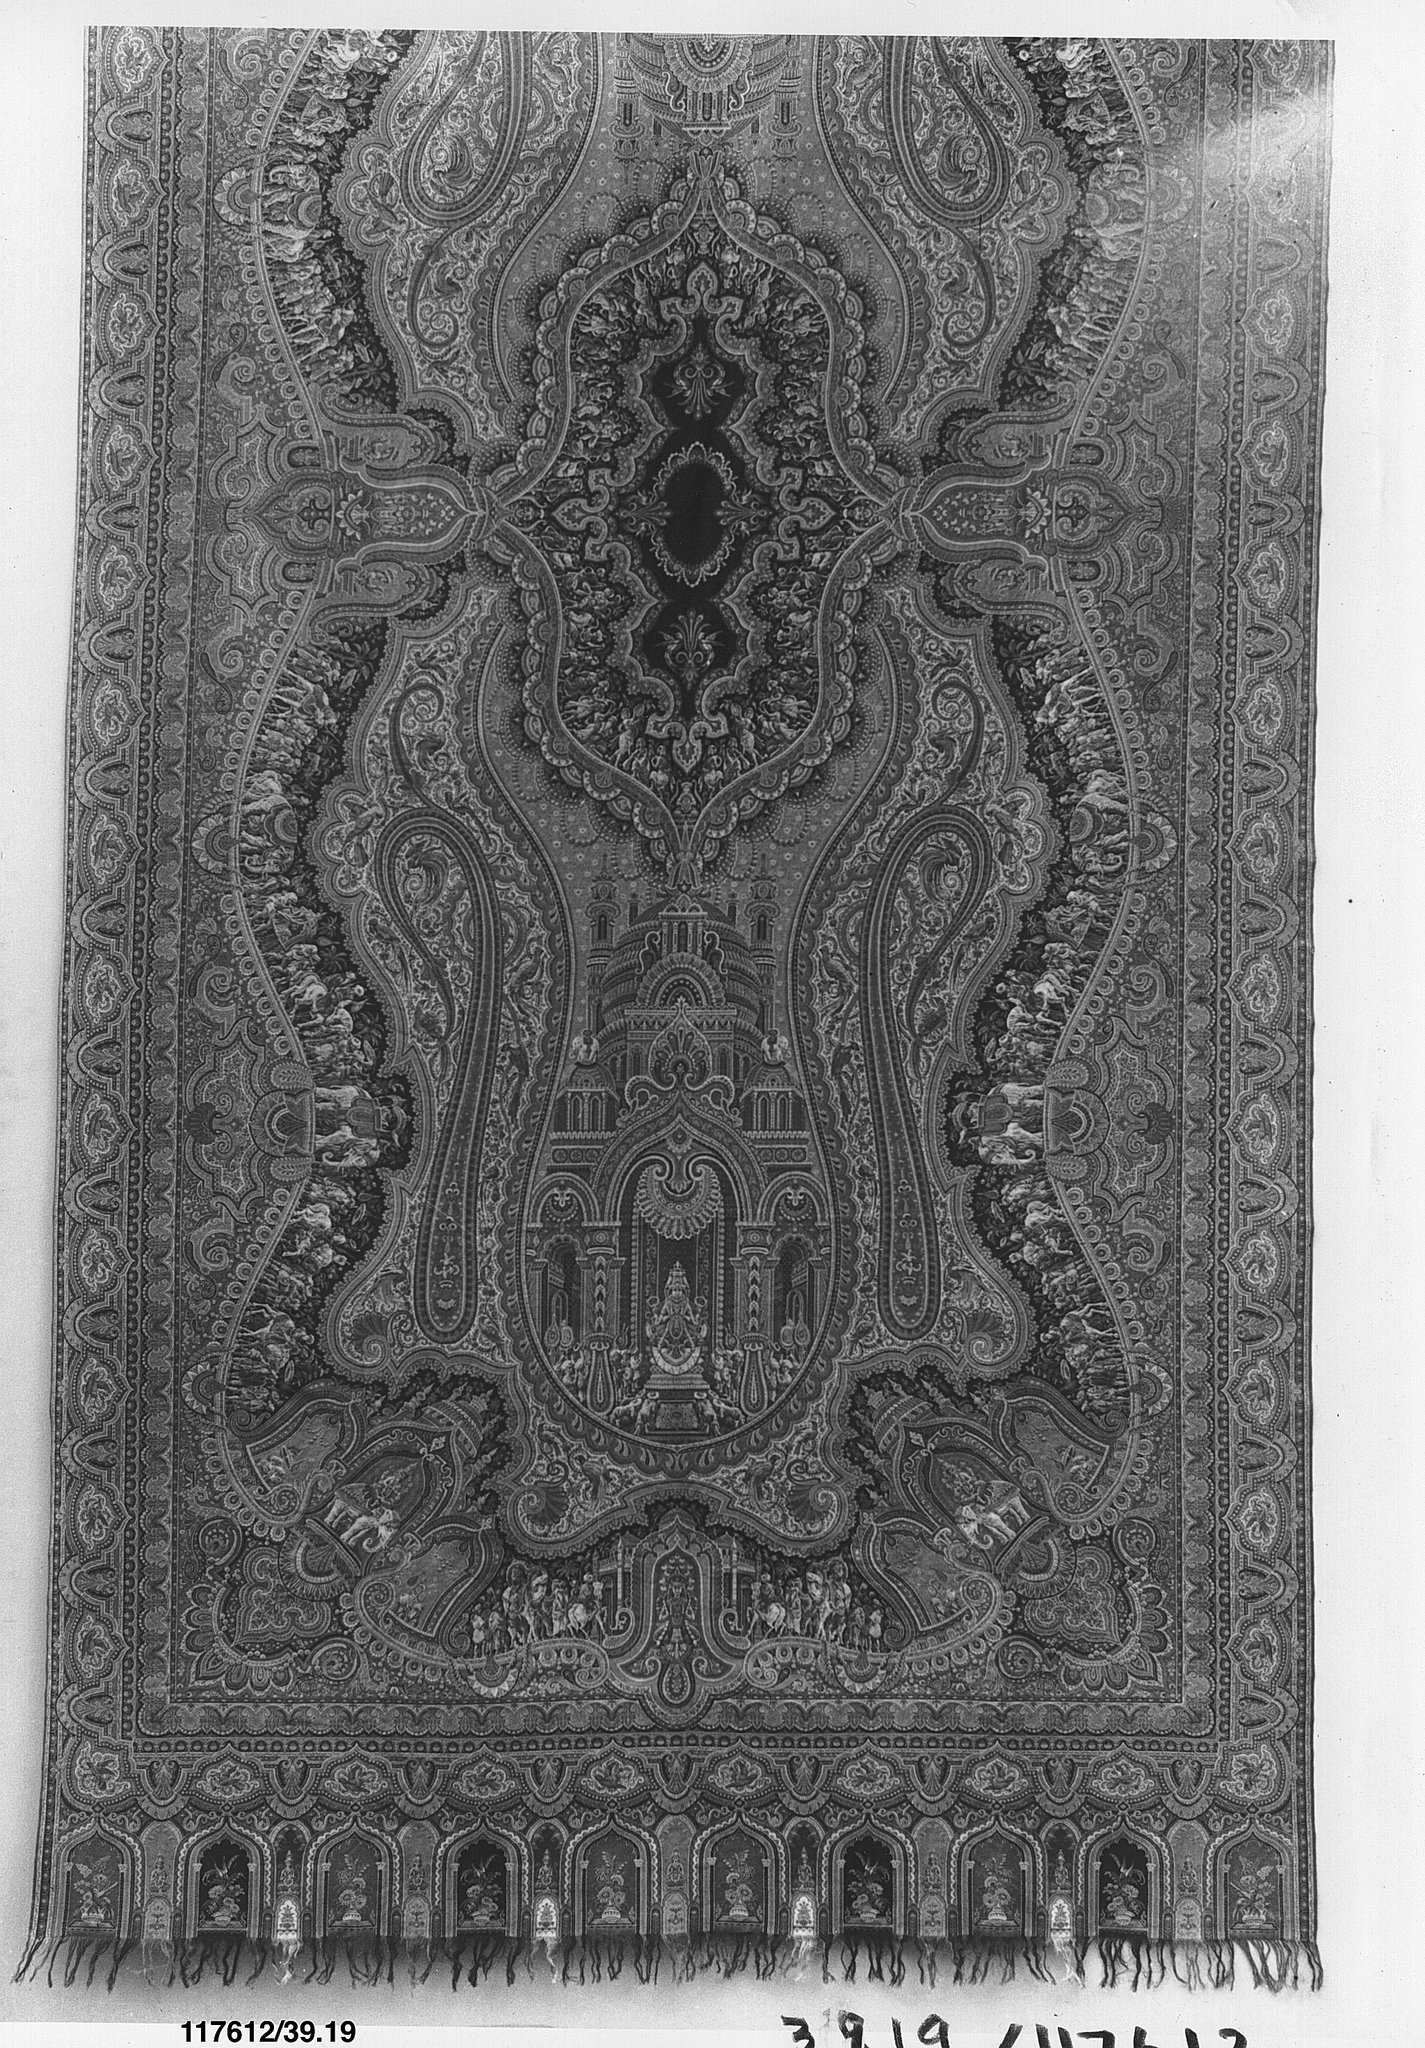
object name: shawl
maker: m. pin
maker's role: maker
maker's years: 1800-1900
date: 1801-1900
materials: silk, wool